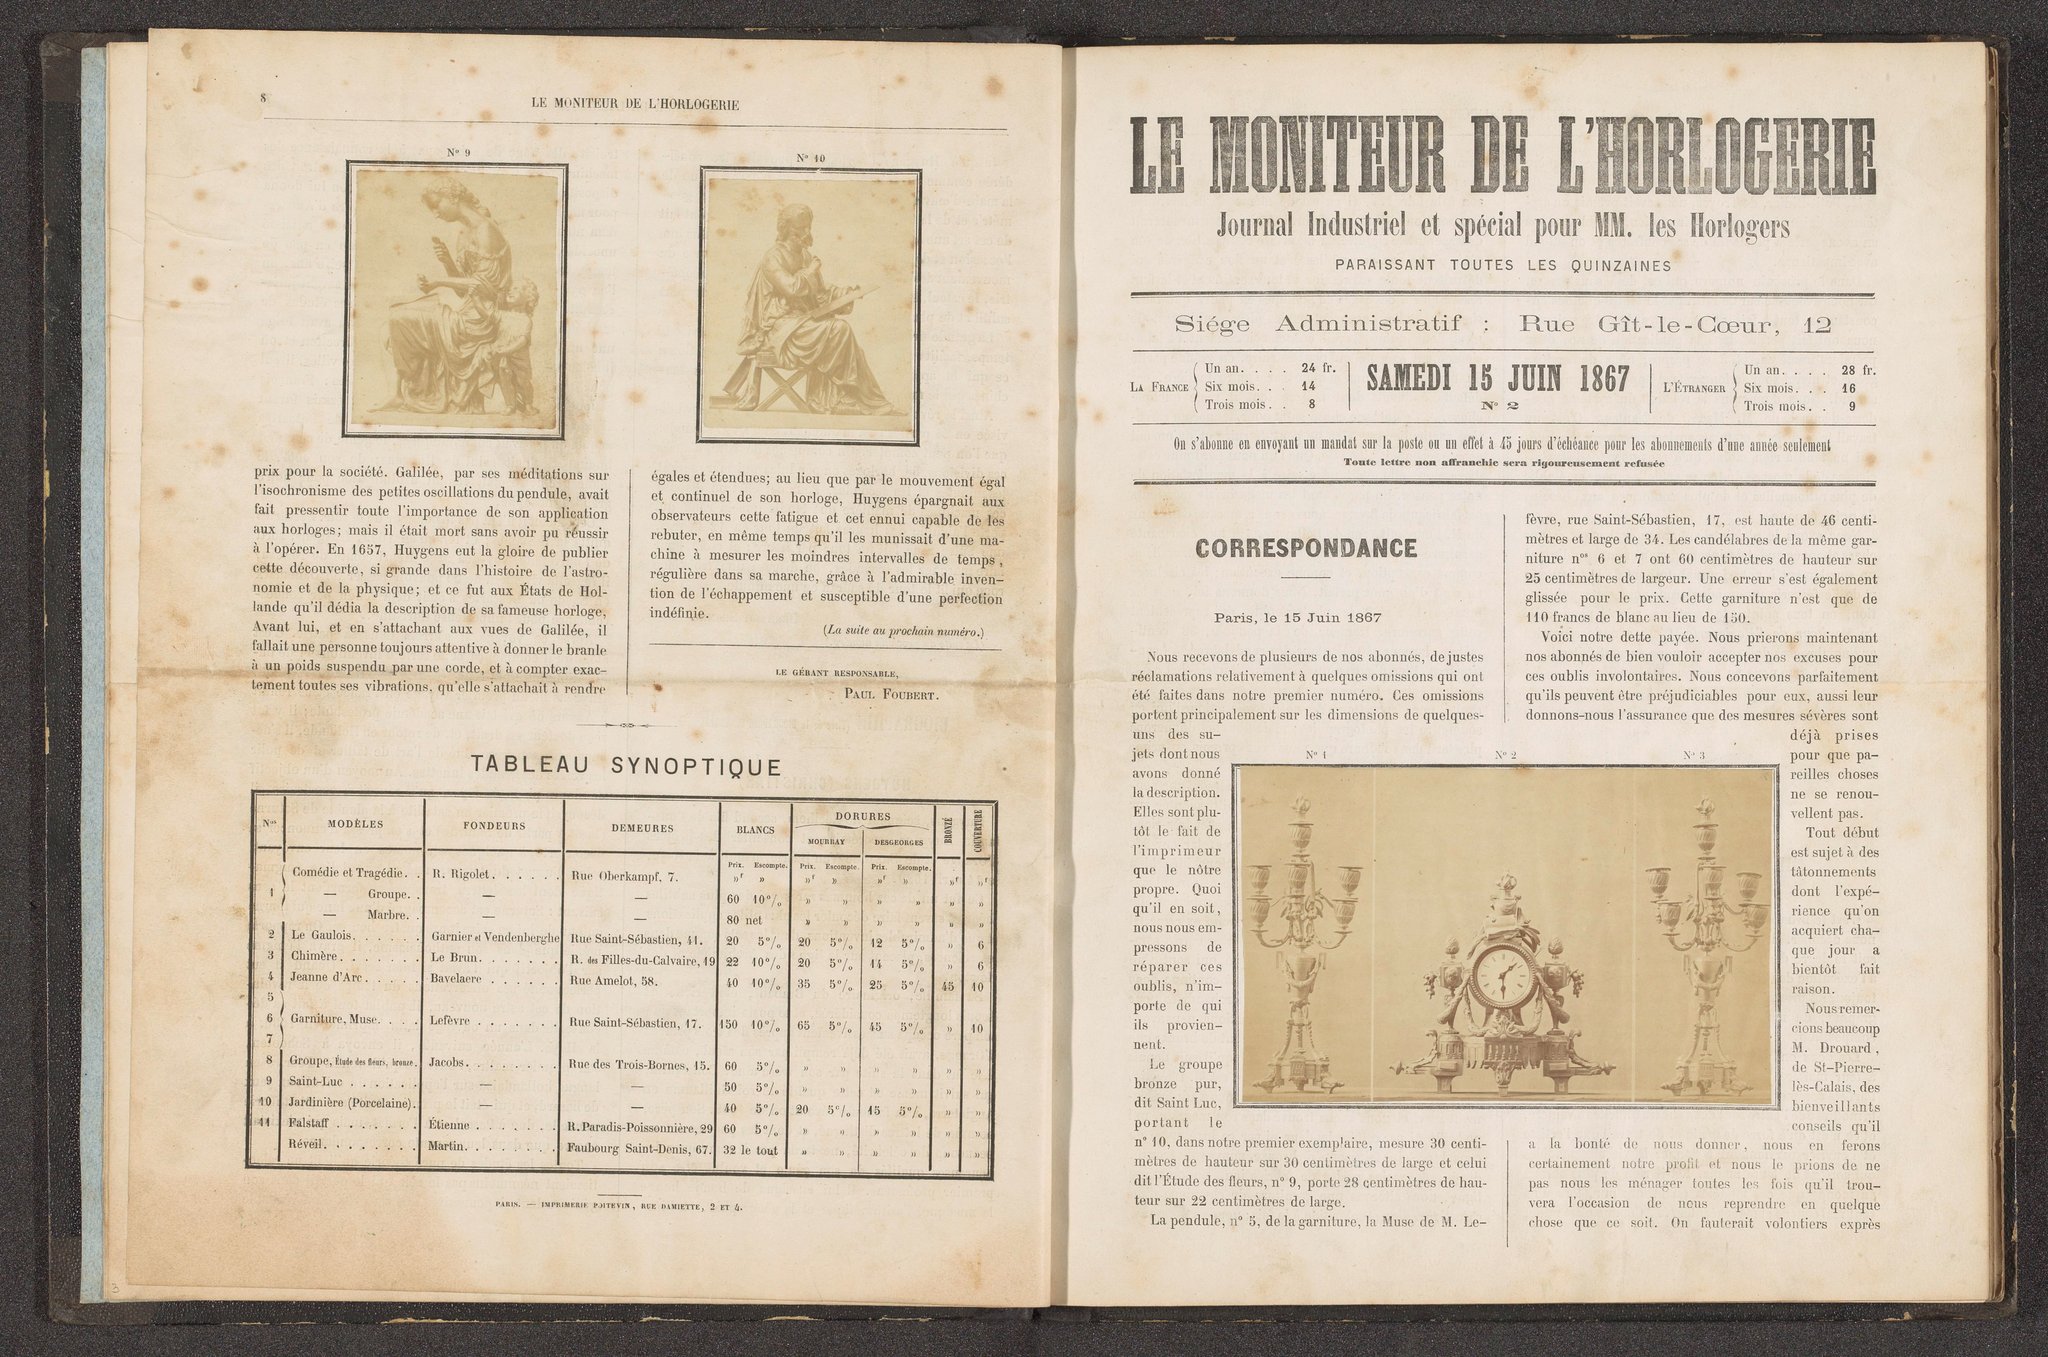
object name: photograph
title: Twee bronzen sculpturen door M. Jacobs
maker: Anonymous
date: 1857-1867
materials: photographic support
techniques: albumen print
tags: piece of sculpture, reproduction of a piece of sculpture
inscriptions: number: ‘No 9 No 10’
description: Links: zittende vrouw met een kind die bloemen bestudeert, rechts: zittende Lucas.